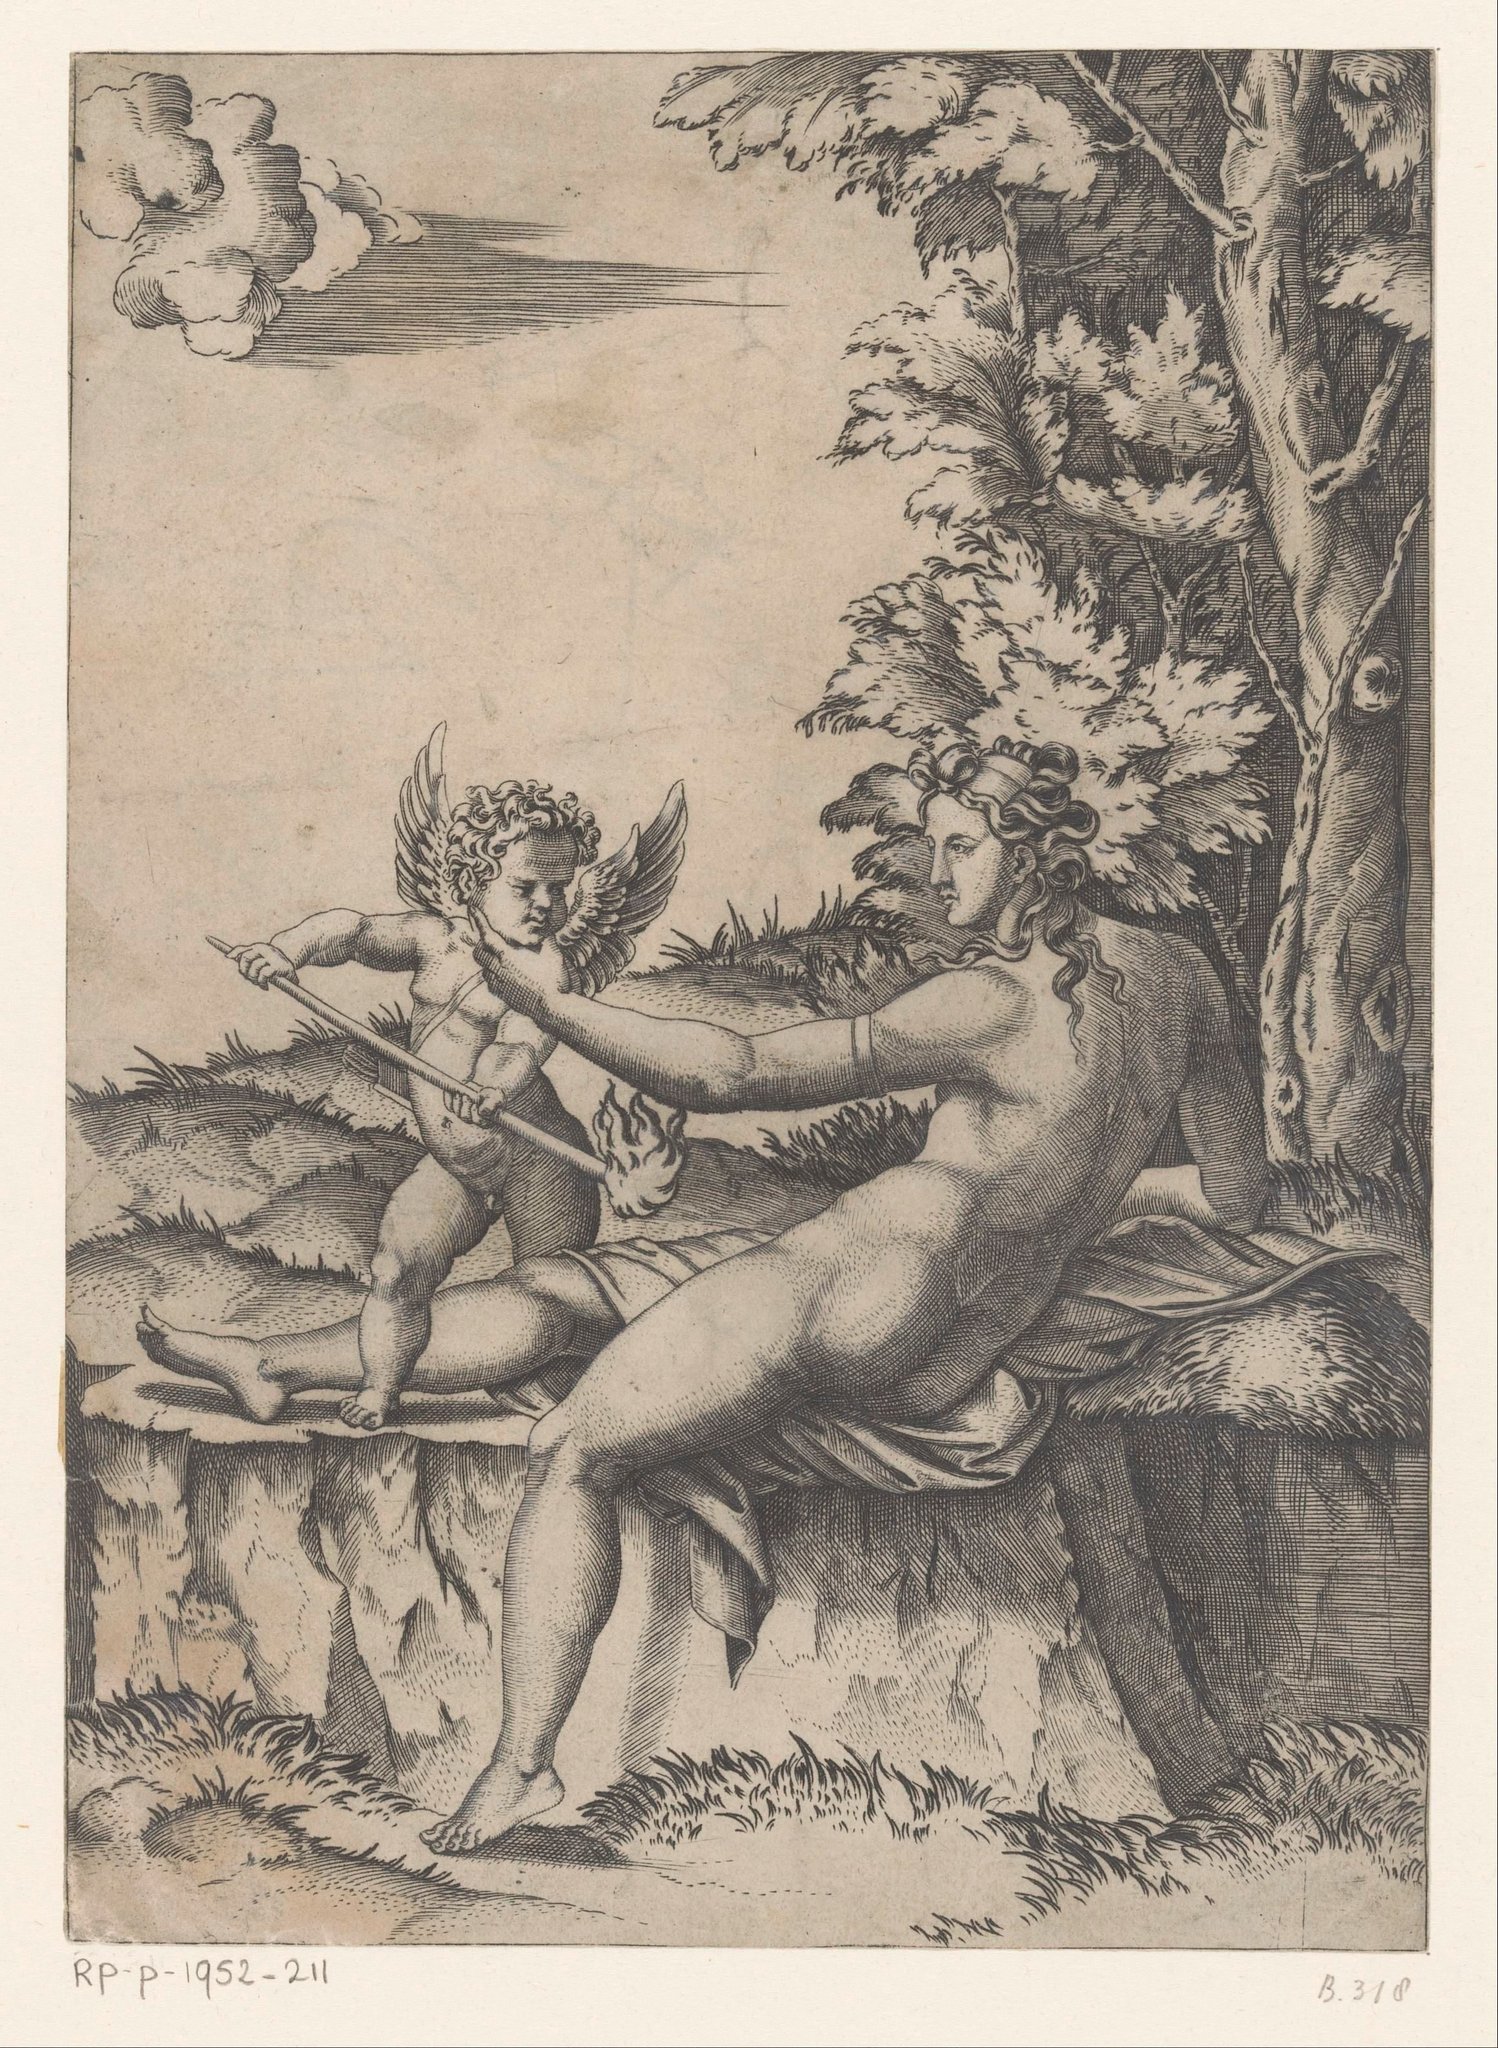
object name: print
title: Venus en Amor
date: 1500-1536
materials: paper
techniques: engraving, etching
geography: italy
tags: attributes of venus: torch, venus and cupid (cupid not being mere attribute)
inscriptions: collector's mark: Lugt 2228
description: Venus zit op de rand van een rotspartij, met haar linkerhand pakt zij het gezicht van Amor vast. Amor houdt met beide handen een brandende fakkel vast. Rechts staat een groep bomen.